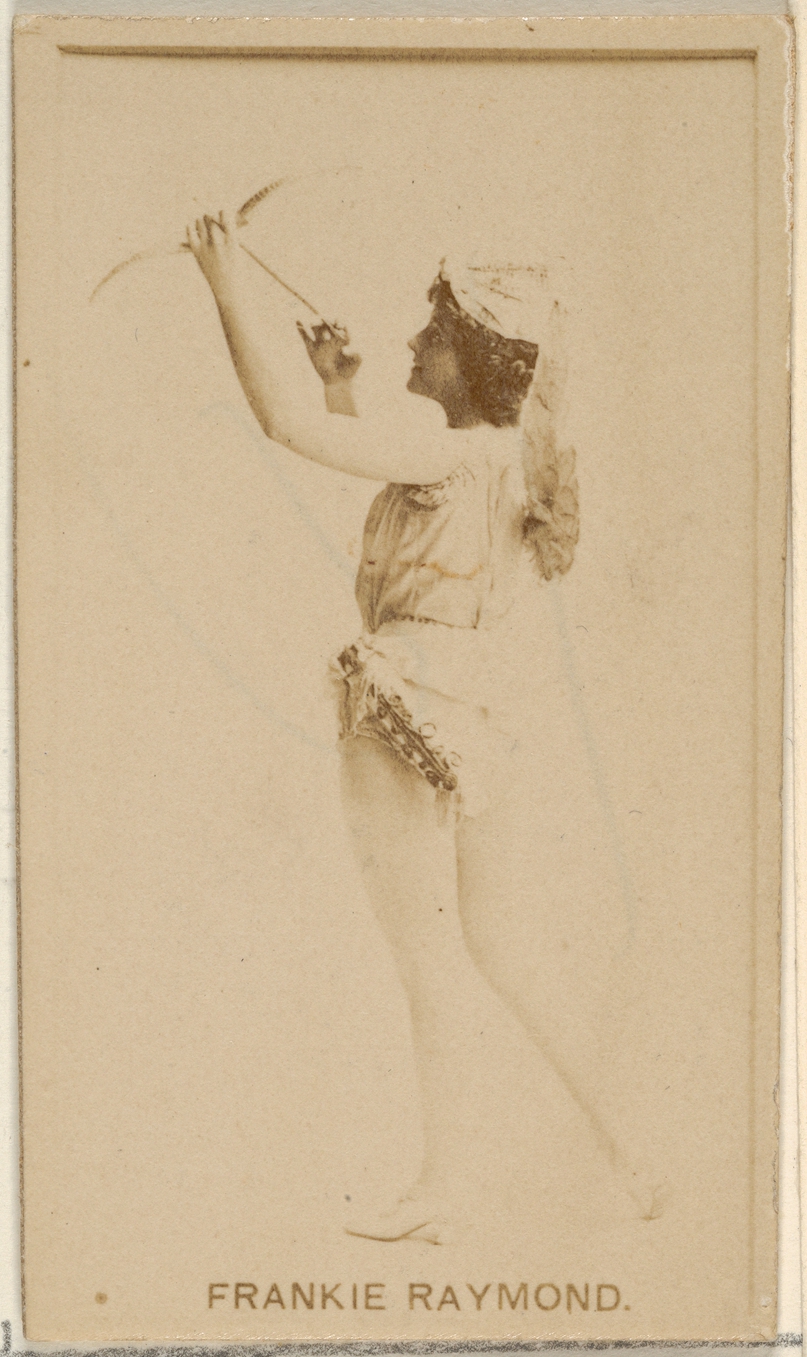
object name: photograph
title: Frankie Raymond, from the Actors and Actresses series (N45, Type 8) for Virginia Brights Cigarettes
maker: allen & ginter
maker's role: publisher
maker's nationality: american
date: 1888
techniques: albumen silver print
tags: bow and arrow,women,actresses